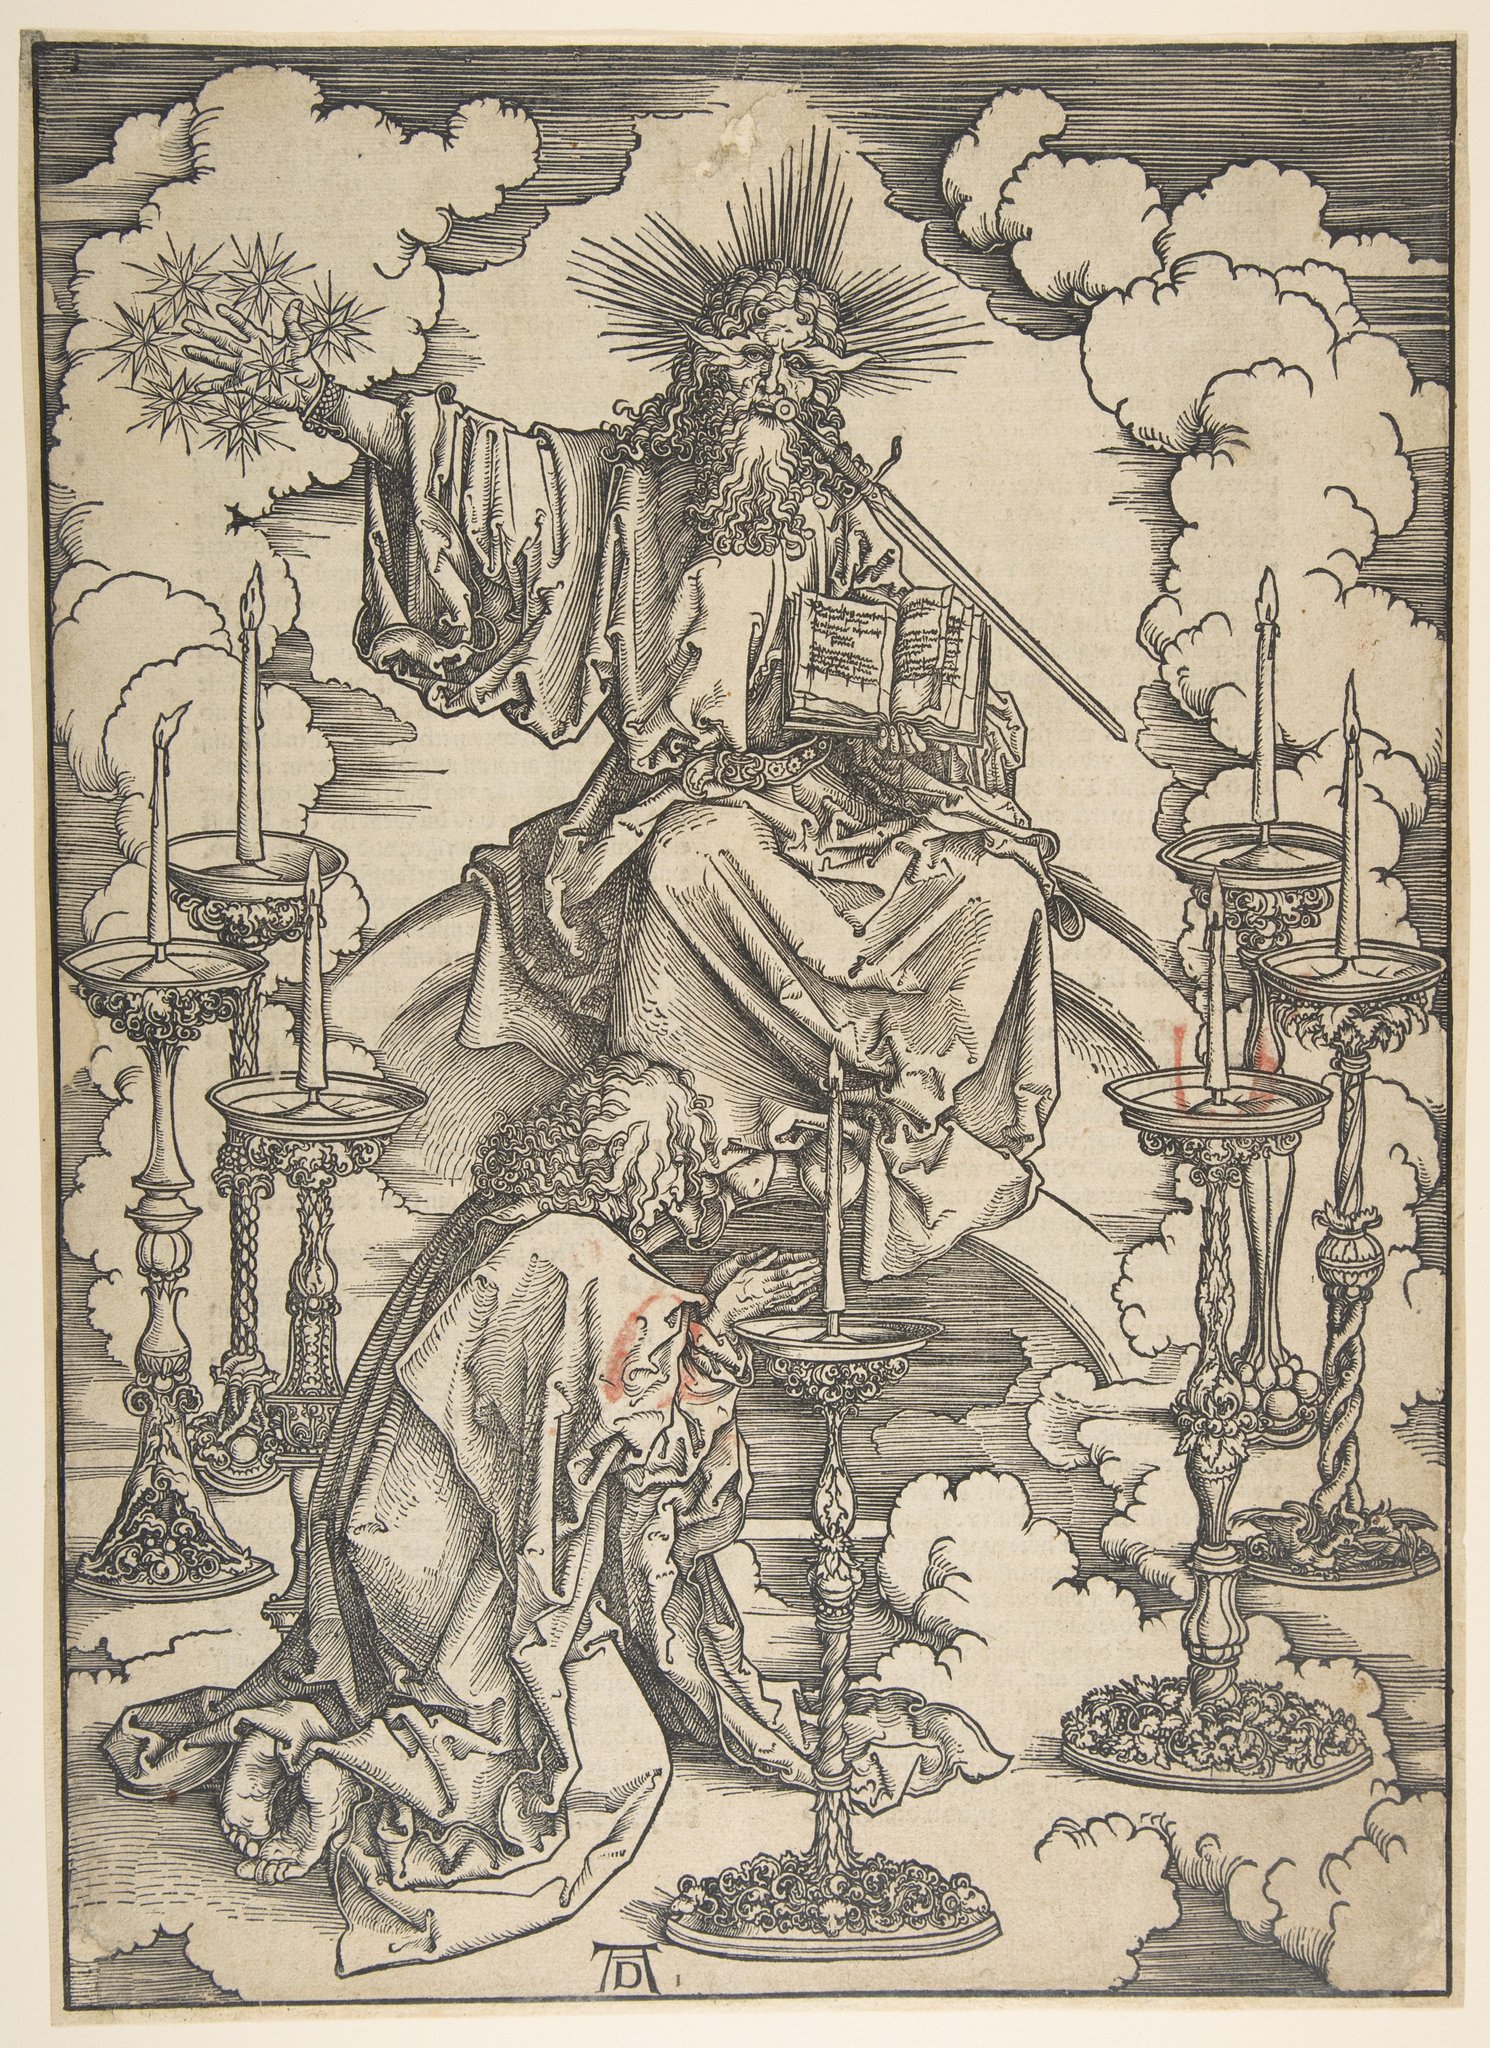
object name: print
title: Saint John Beholding the Seven Golden Candlesticks, from "The Apocalypse"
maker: albrecht dürer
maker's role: artist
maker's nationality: german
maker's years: 1471-1528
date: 1497-1498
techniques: woodcut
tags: saint john the baptist,candlesticks